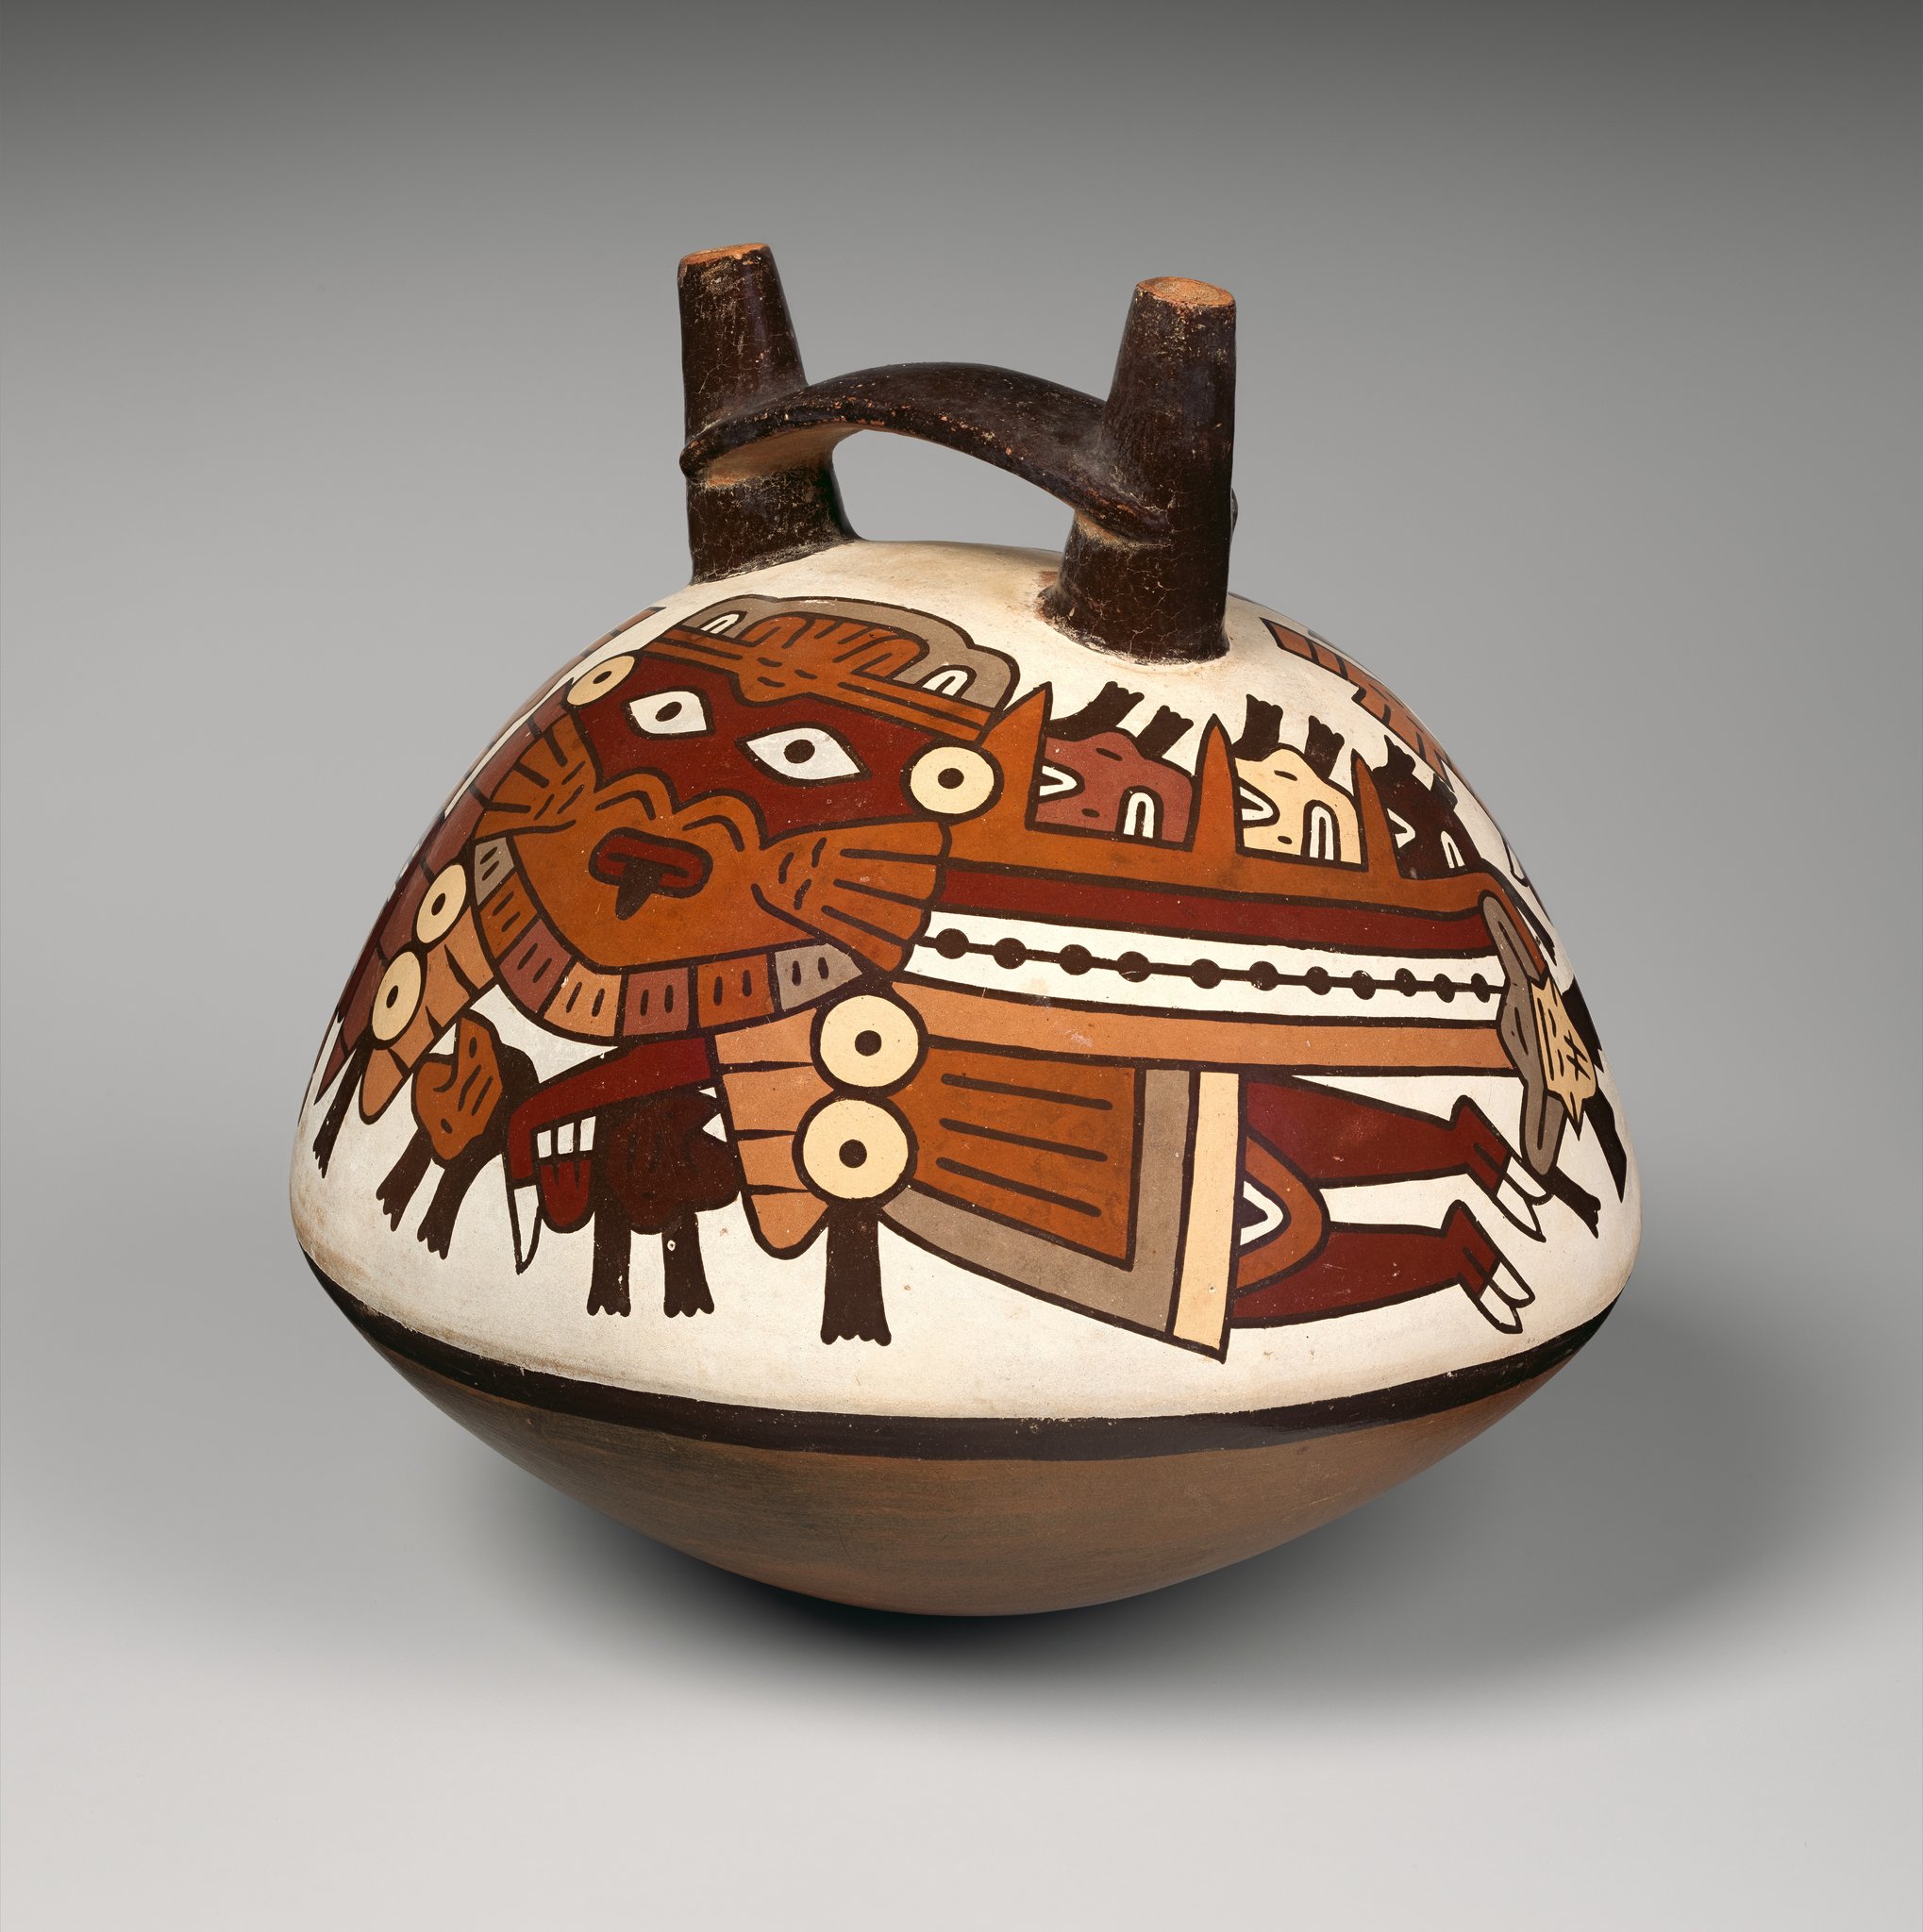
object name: bottle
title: Double-spout bottle with flying figure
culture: nasca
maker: nasca artist(s)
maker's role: artist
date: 300-500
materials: ceramic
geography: peru